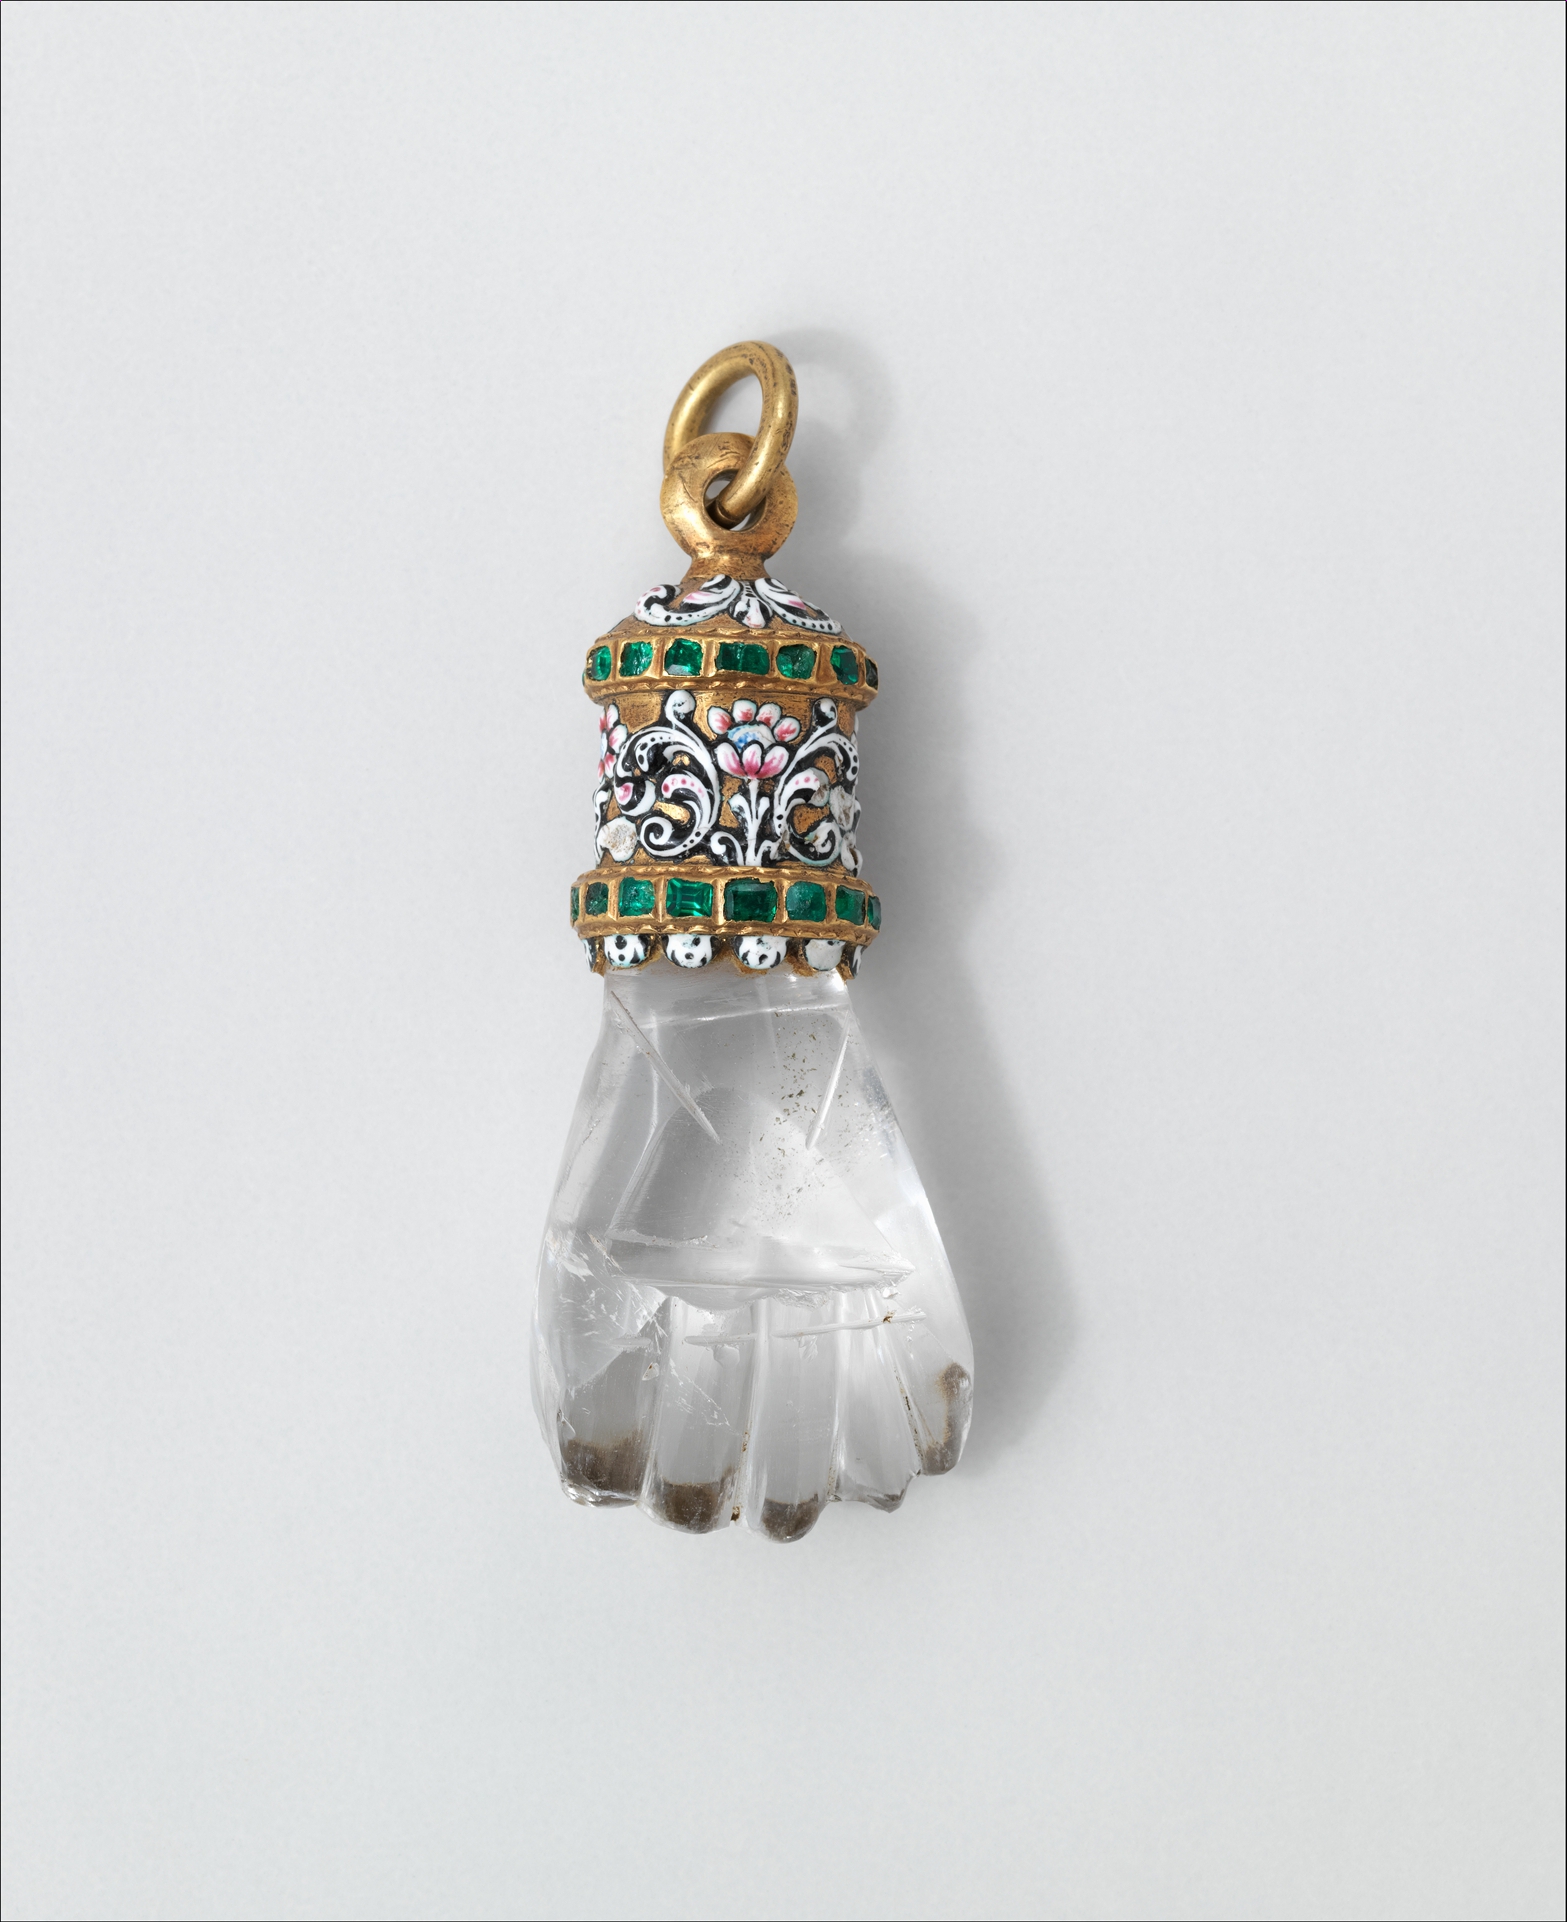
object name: pendant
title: Pendant in the form of a hand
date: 1601-1650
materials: gemstone, gold, quartz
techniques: enamel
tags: hands